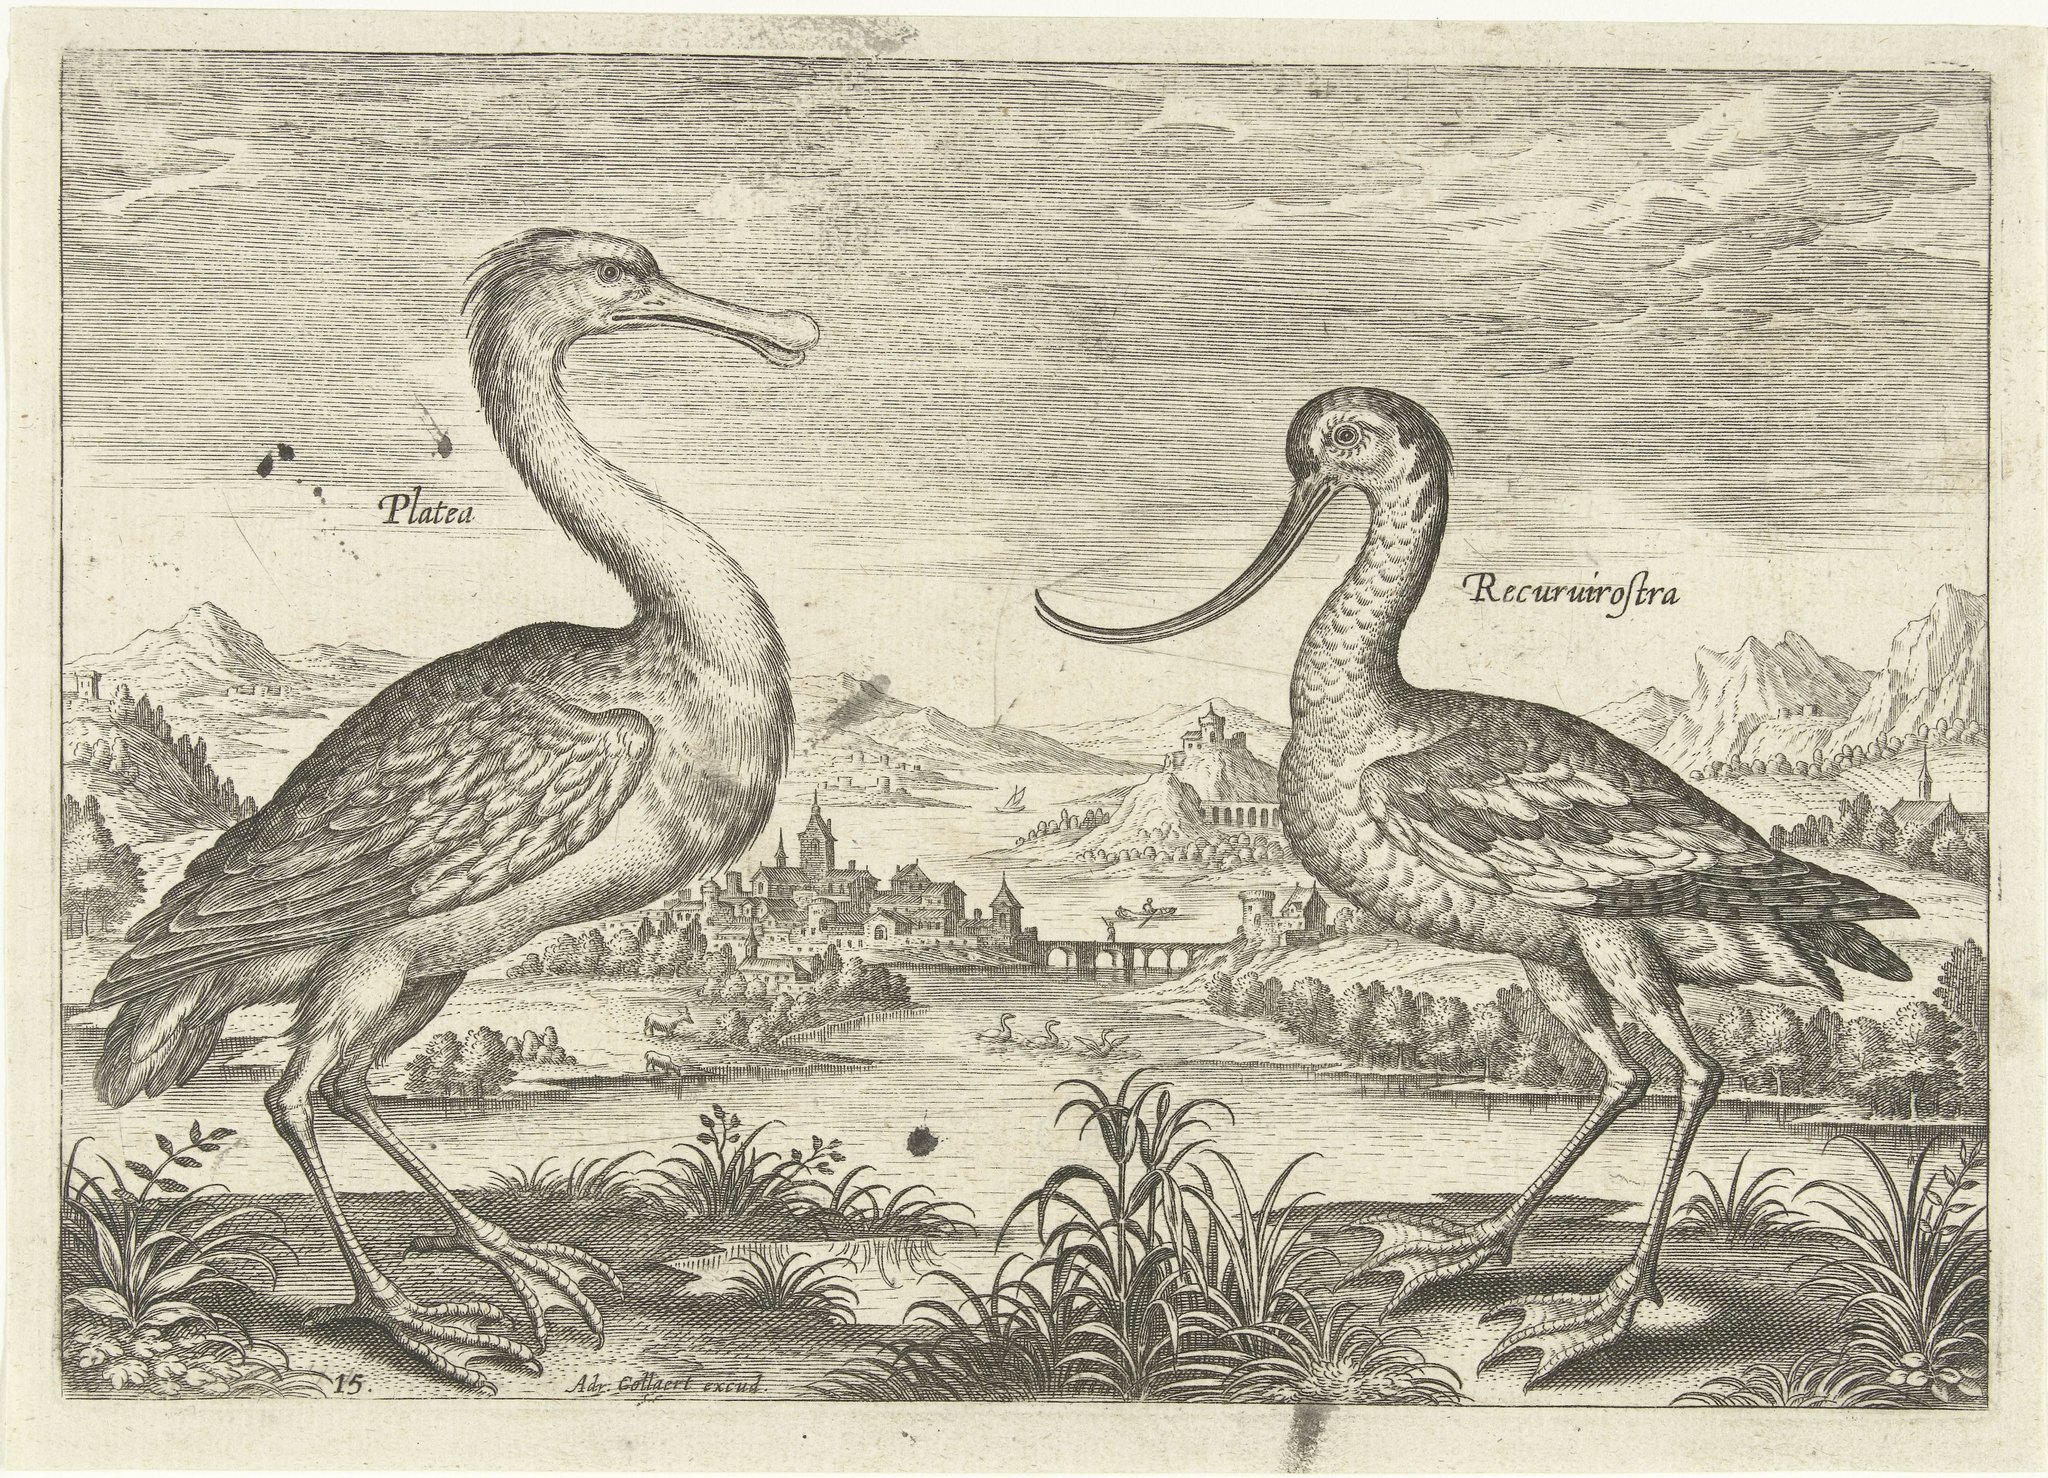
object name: print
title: Twee waadvogels in een rivierlandschap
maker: adriaen collaert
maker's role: draughtsman, print maker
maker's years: 1560-1618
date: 1598-1602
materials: paper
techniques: engraving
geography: antwerp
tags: river bank, shore-birds and wading-birds: avocet, shore-birds and wading-birds: spoonbill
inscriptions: collector's mark: Lugt 2228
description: Een lepelaar en een kluut op de voorgrond. Op de achtergrond een rivierlandschap. De prent maakt deel uit van een serie met vogels als onderwerp.